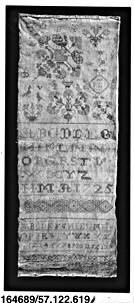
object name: sampler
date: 1725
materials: linen, silk